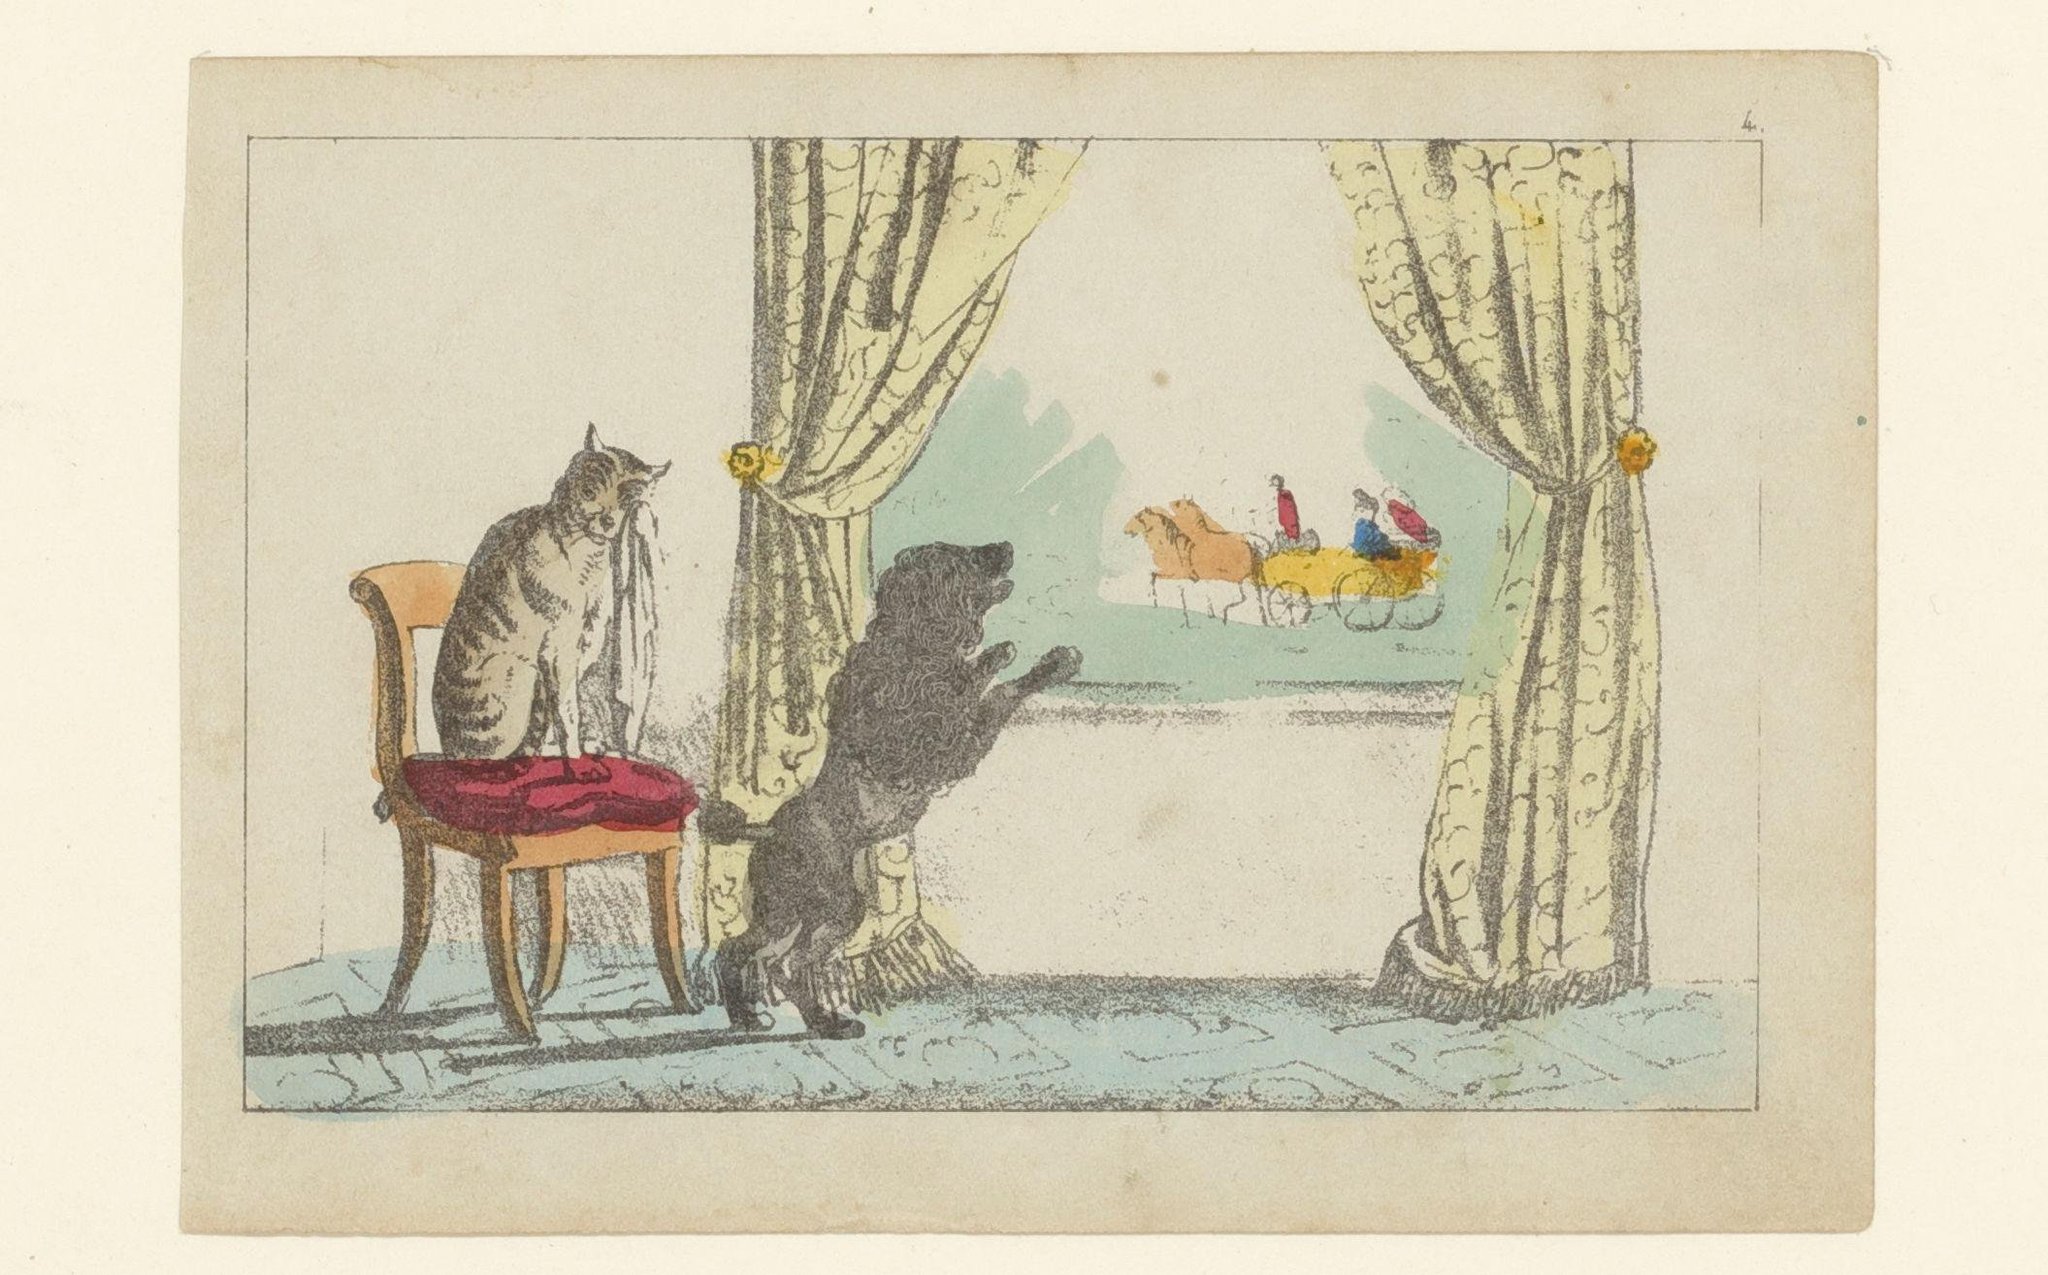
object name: print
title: Kardoes en Muizenschik kijken door het raam hoe hun baas vertrekt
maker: Anonymous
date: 1841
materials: paper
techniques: hand coloring, lithograph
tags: window, cat, four-wheeled vehicle drawn by two animals, dog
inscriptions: collector's mark: Lugt 1641, stamp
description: Rechtsboven genummerd: 4. Onderwerpsrubrieken binnen de Atlas Zeden en Gewoonten: Zeden en Gewoonten in Engeren Zin, Des menschen beging, midden en einde, Kinderleven – Kinderspel en Kinderprenten.